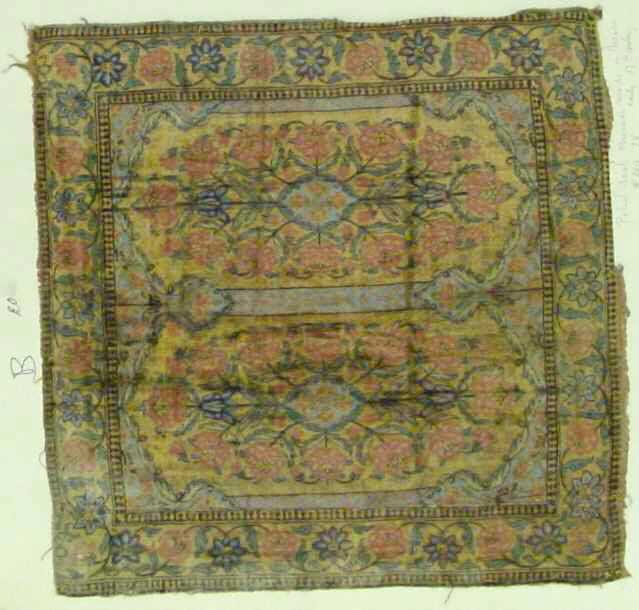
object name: textile fragment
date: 1601-1633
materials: metal thread, silk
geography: iran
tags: flowers